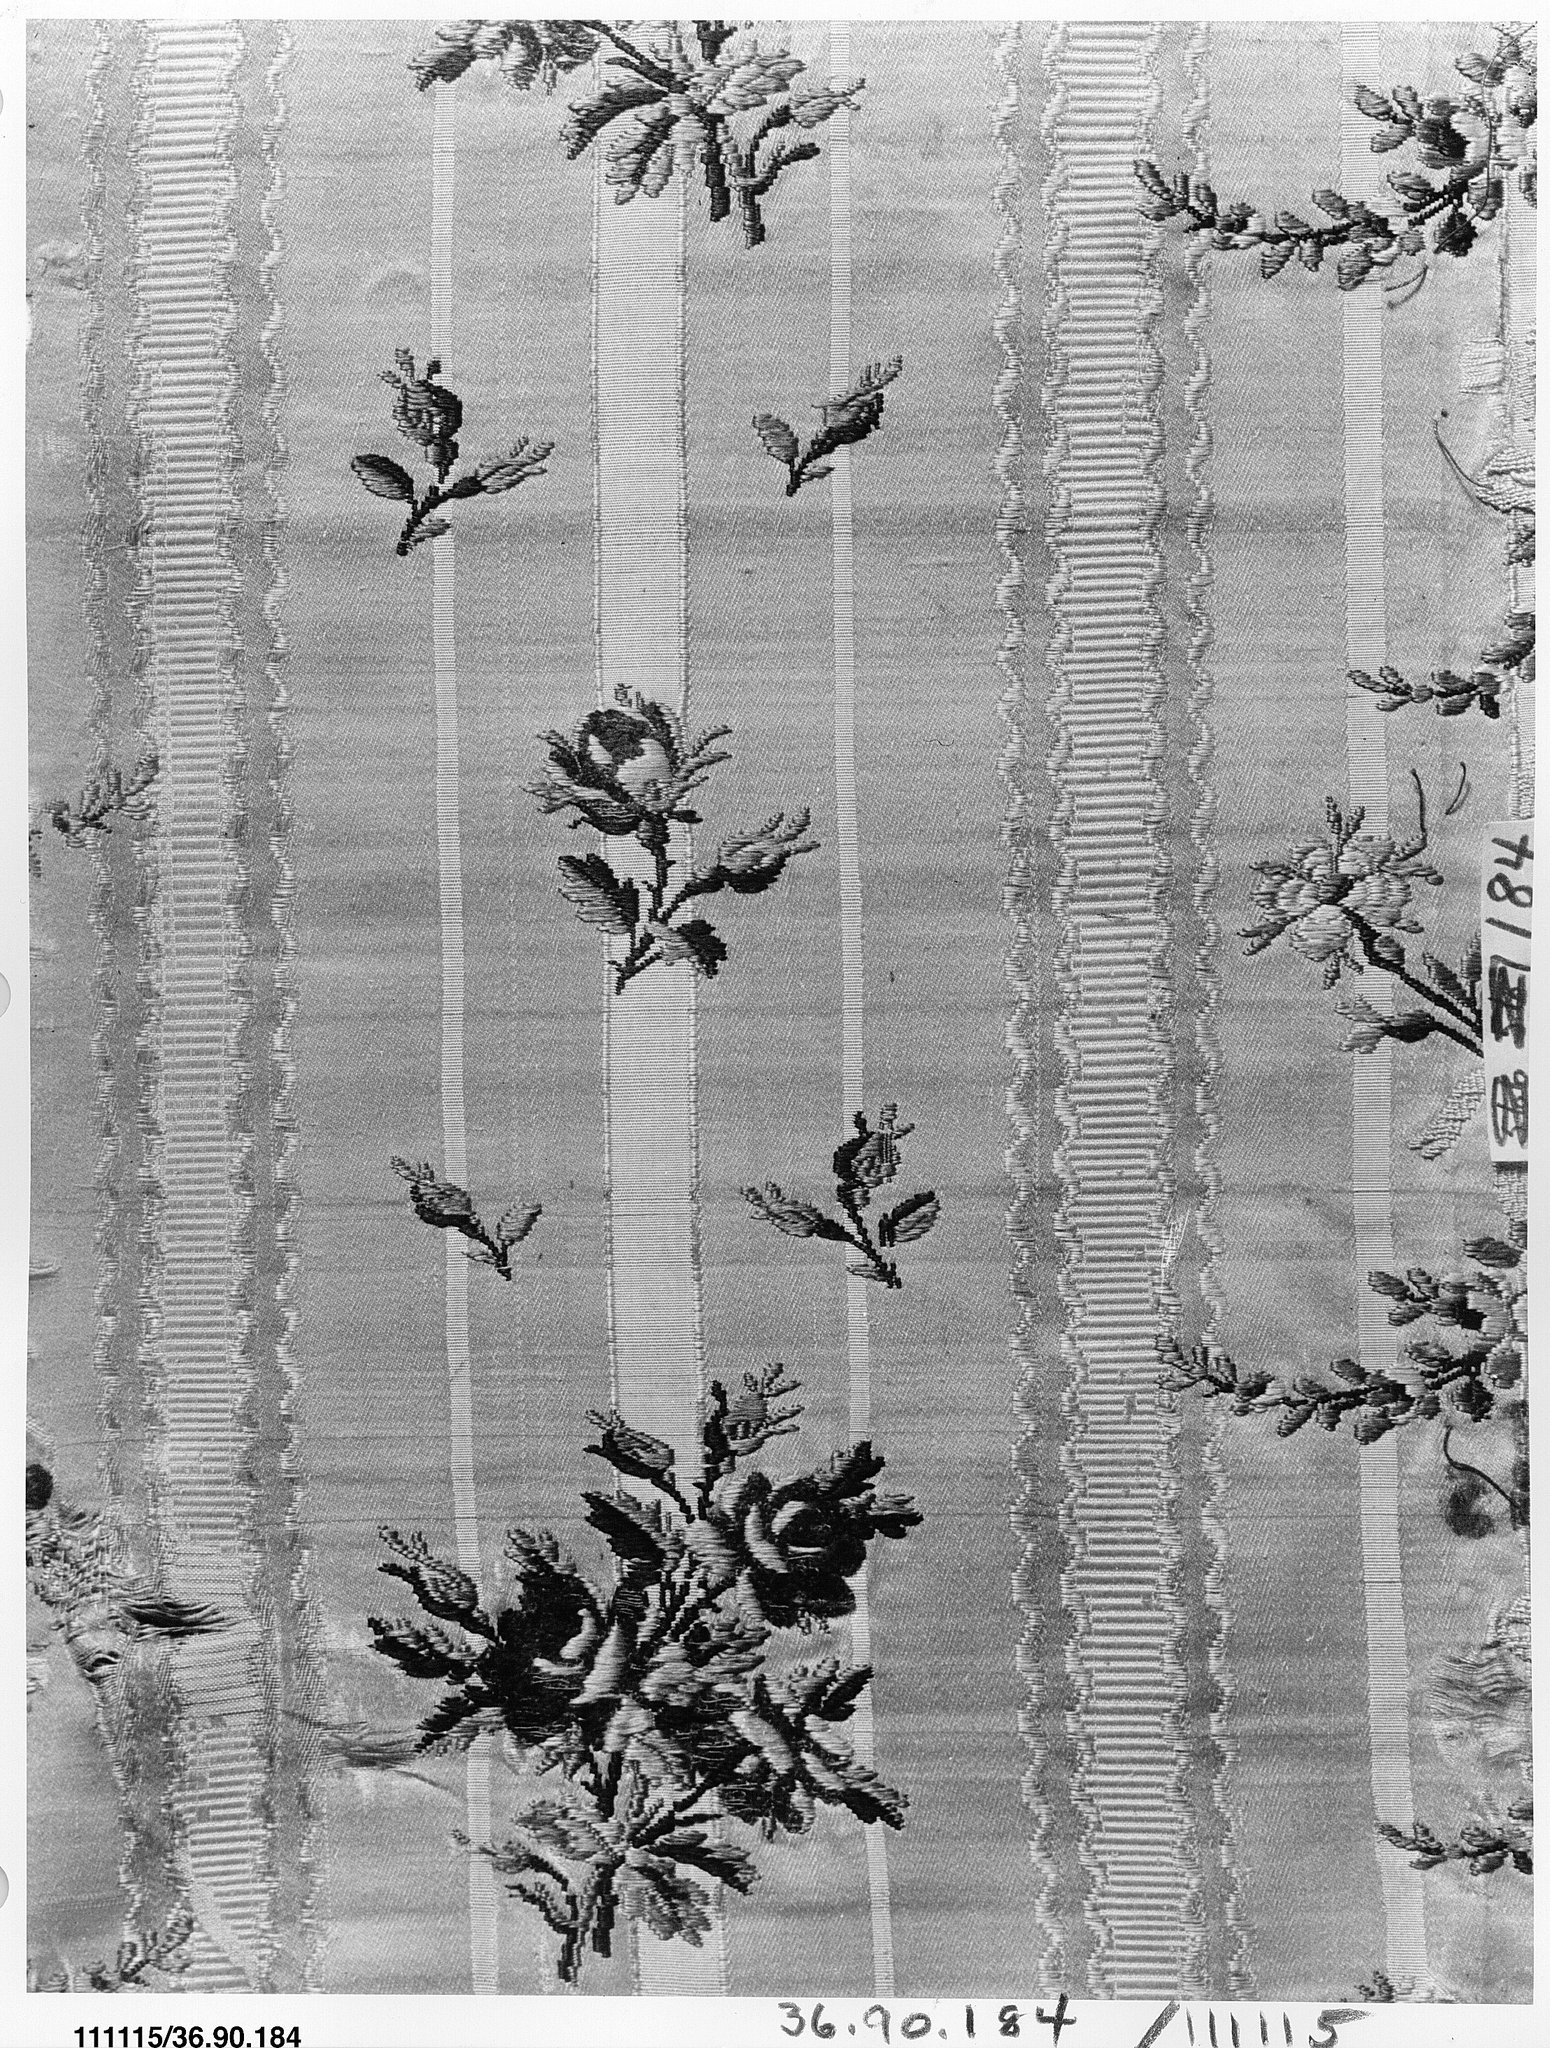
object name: piece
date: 1701-1800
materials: silk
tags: flowers